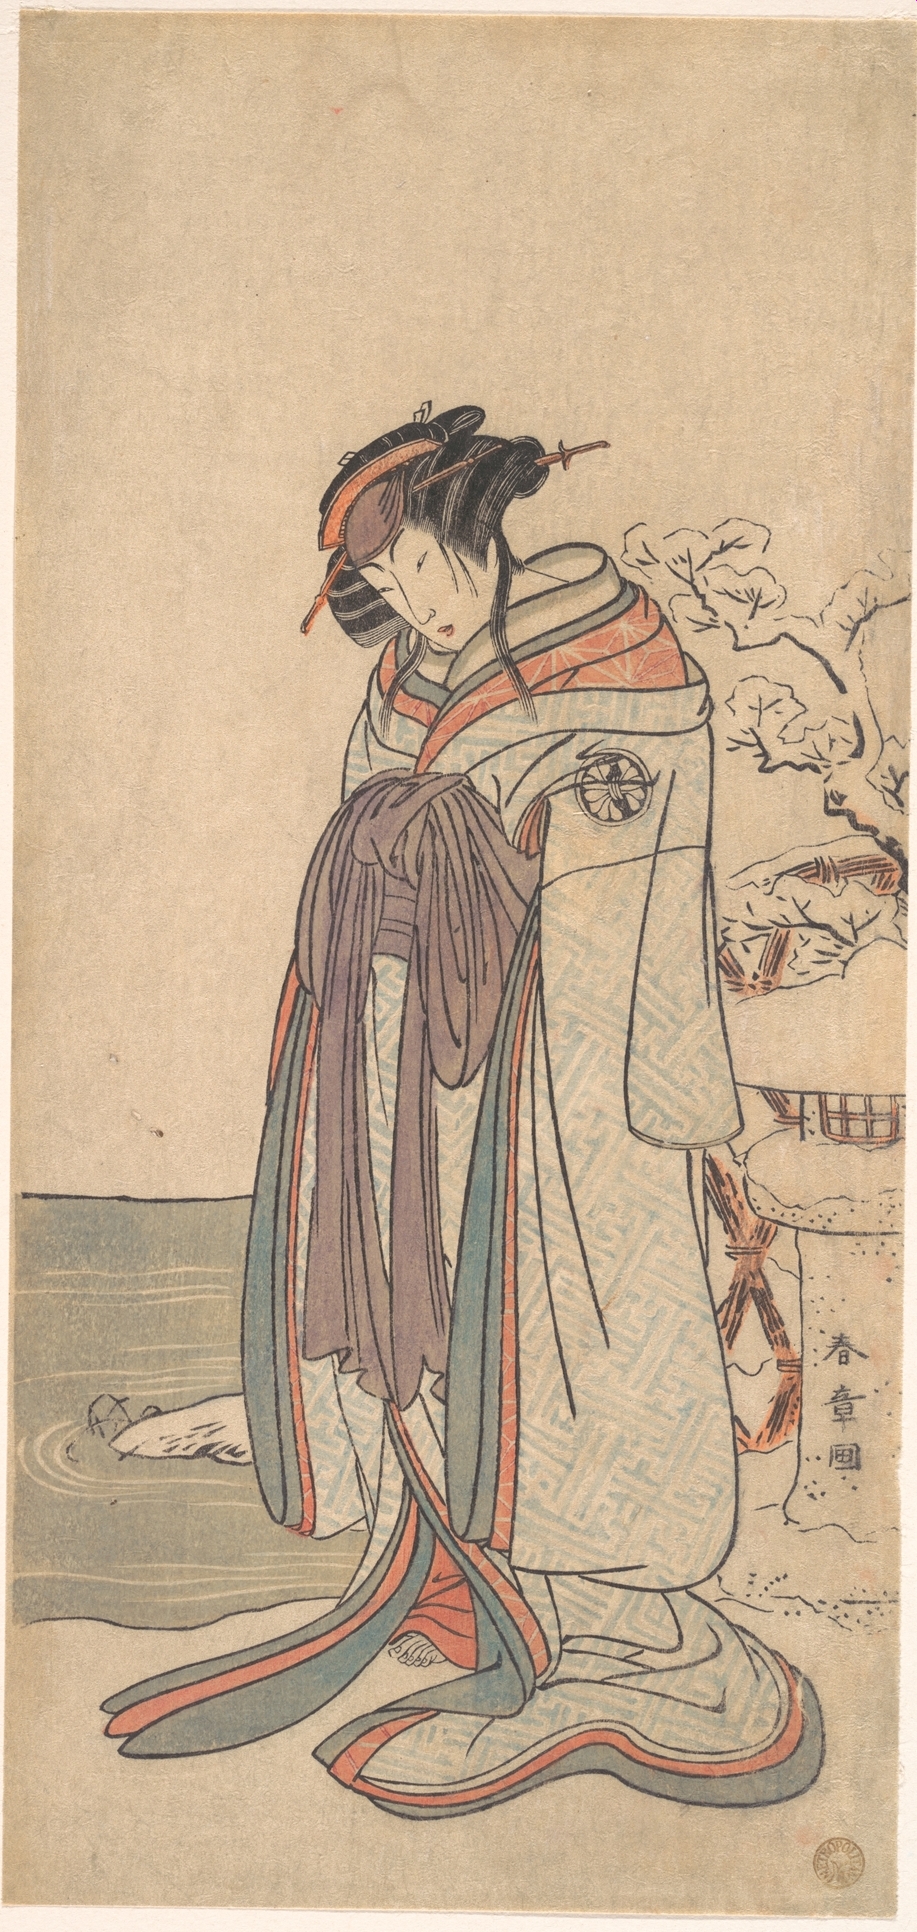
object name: woodblock print nishiki e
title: The Third Segawa Kikunojo as a Courtesan Standing in the Snow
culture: japanese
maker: katsukawa shunshō 勝川春章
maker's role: artist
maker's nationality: japanese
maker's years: 1726-1792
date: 1775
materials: ink, paper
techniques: nishiki e, woodblock print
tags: women,actors